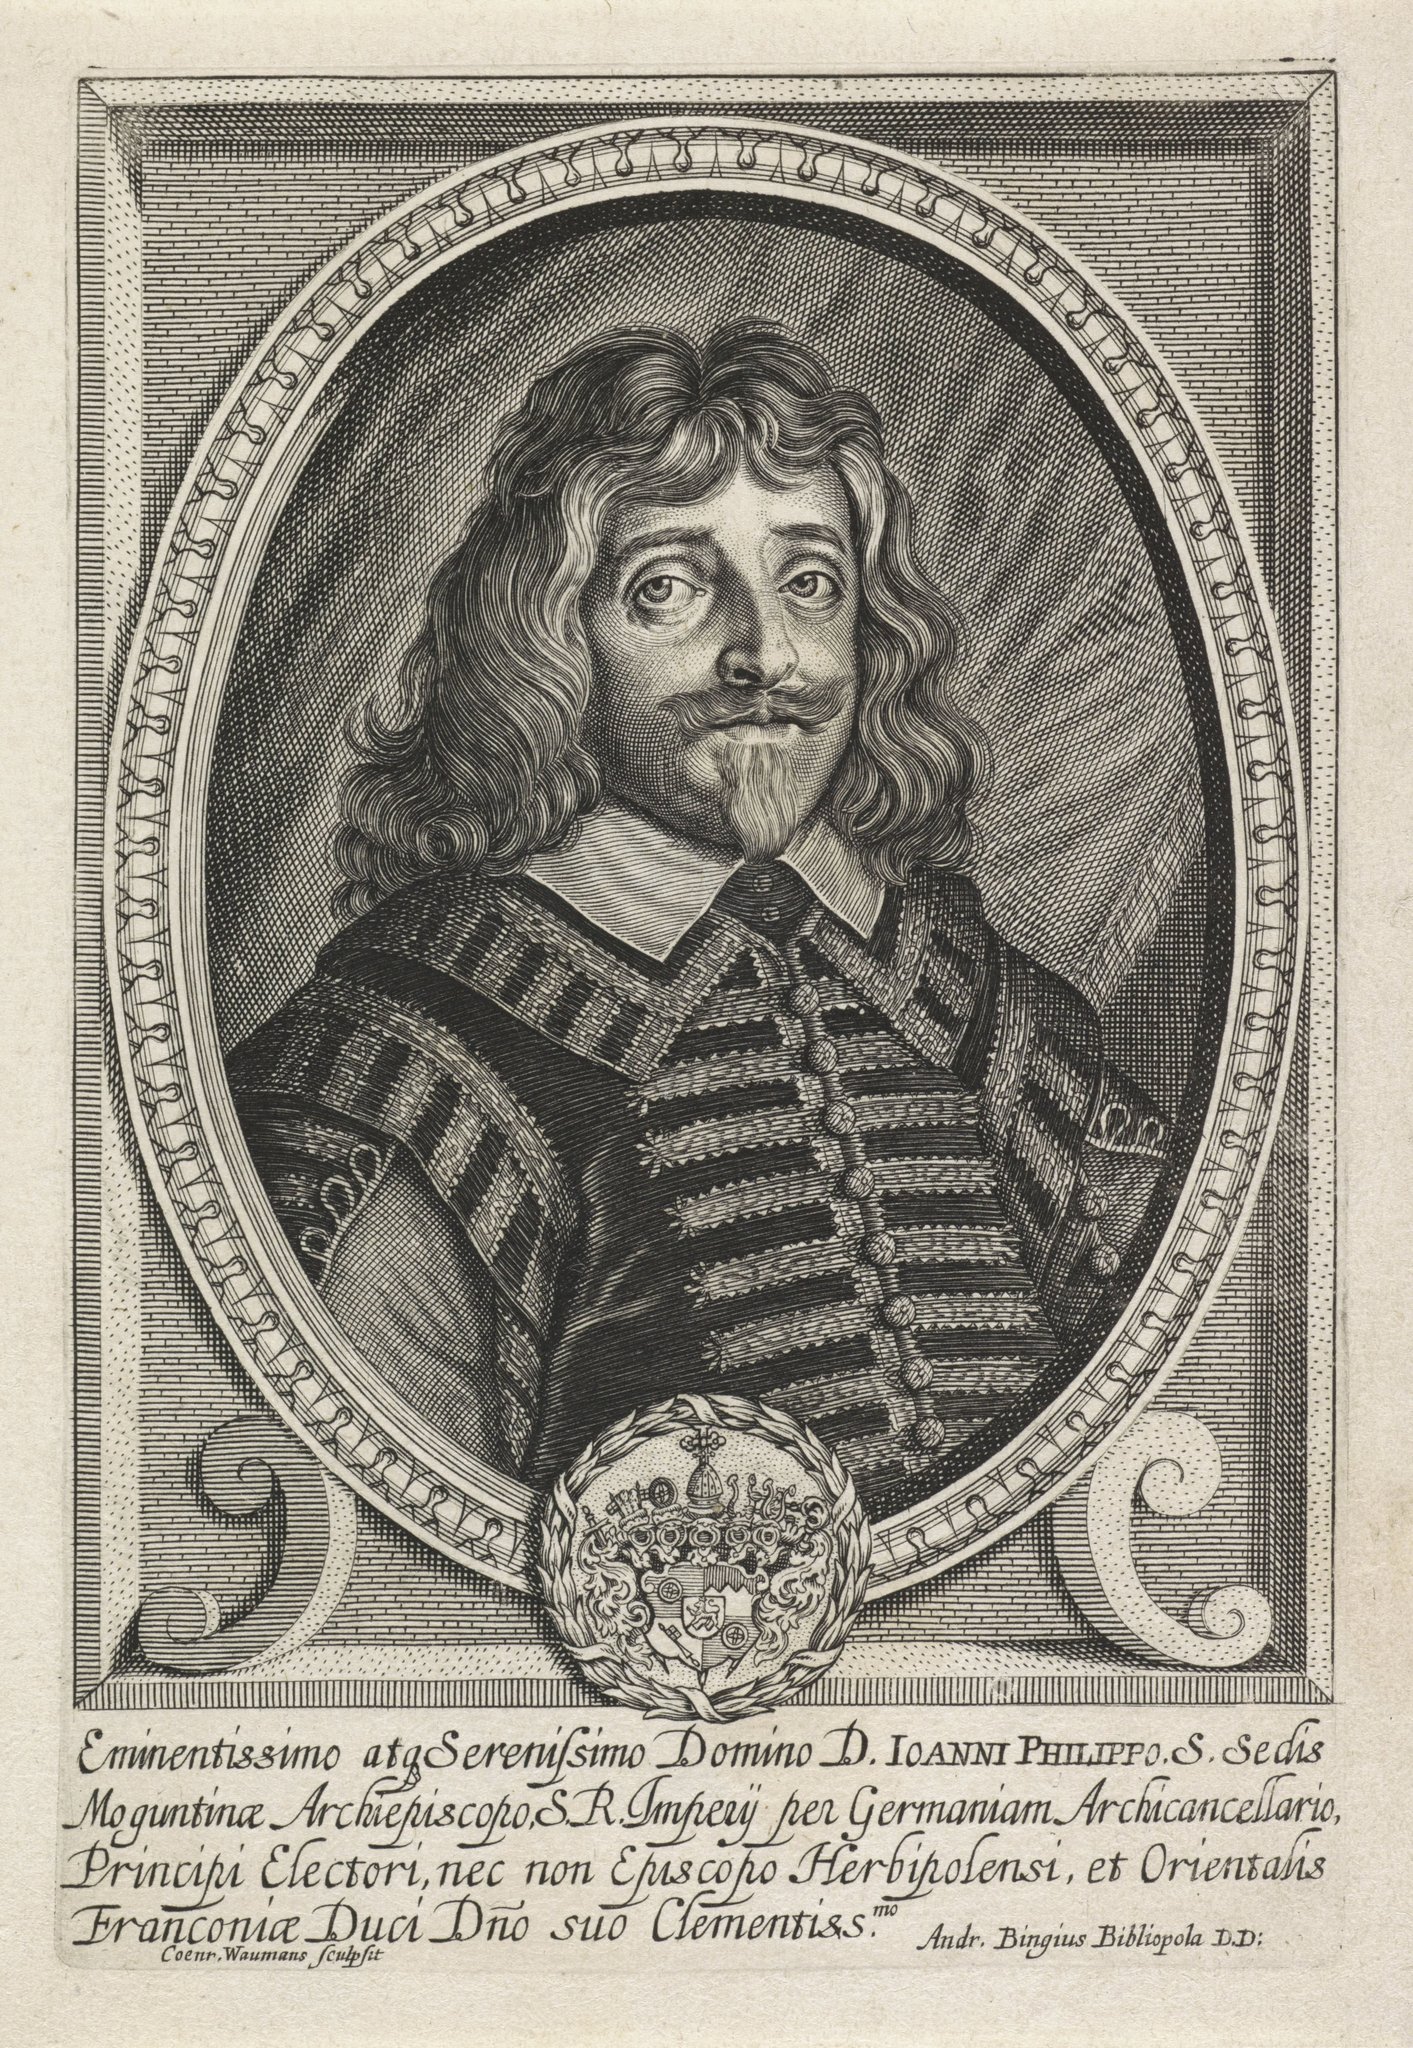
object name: print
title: Portret van Johann Philipp von Schönborn, aartsbisschop van Mainz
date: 1633-1673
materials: paper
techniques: engraving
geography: antwerp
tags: armorial bearing, heraldry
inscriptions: collector's mark: Lugt 2233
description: Portret van Johann Philipp von Schönborn, aartsbisschop van Mainz. Op de omlijsting zijn wapenschild. In de marge een vierregelig onderschrift in het Latijn.